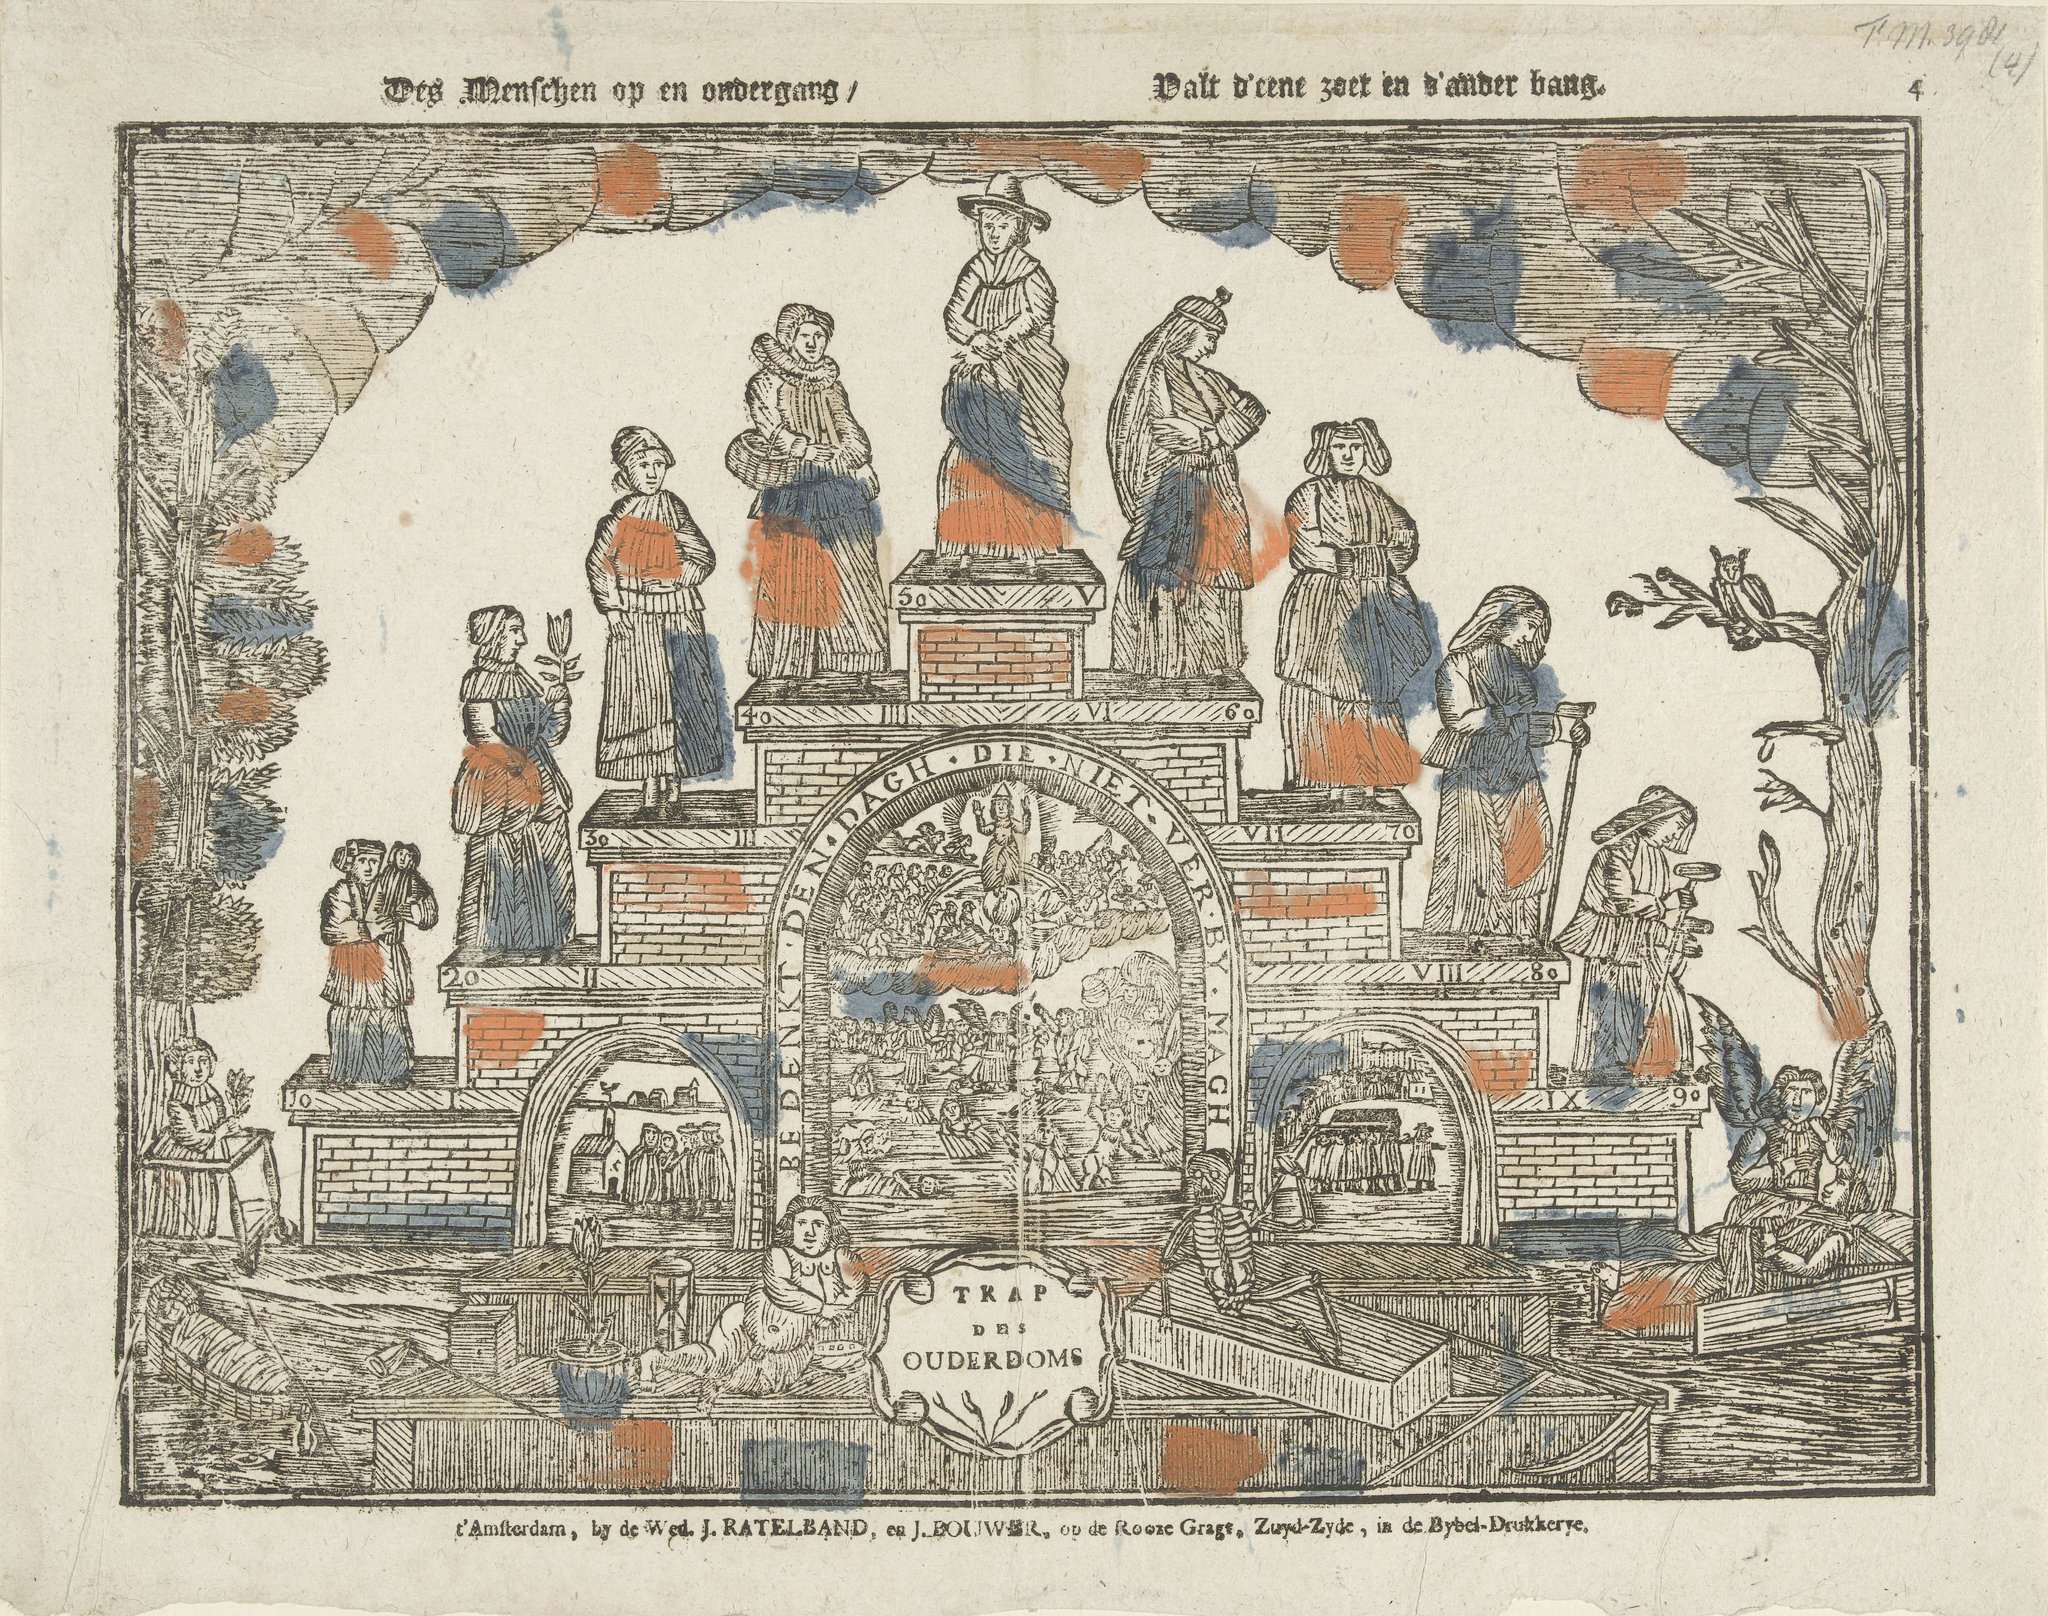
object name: print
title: Trap des ouderdoms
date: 1767-1778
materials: paper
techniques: colour, letterpress printing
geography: netherlands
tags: the ages of man represented by a staircase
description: Een trap des ouderdoms: een vrouwentrap. Op de treden van de trap, in de vorm van een brug, staan vrouwen in de leeftijd van 0 tot 100 jaar. Onder de brug een voorstelling van het Laatste Oordeel. Linksvoor een putto en rechtsvoor de dood. Genummerd rechtsboven: 4.